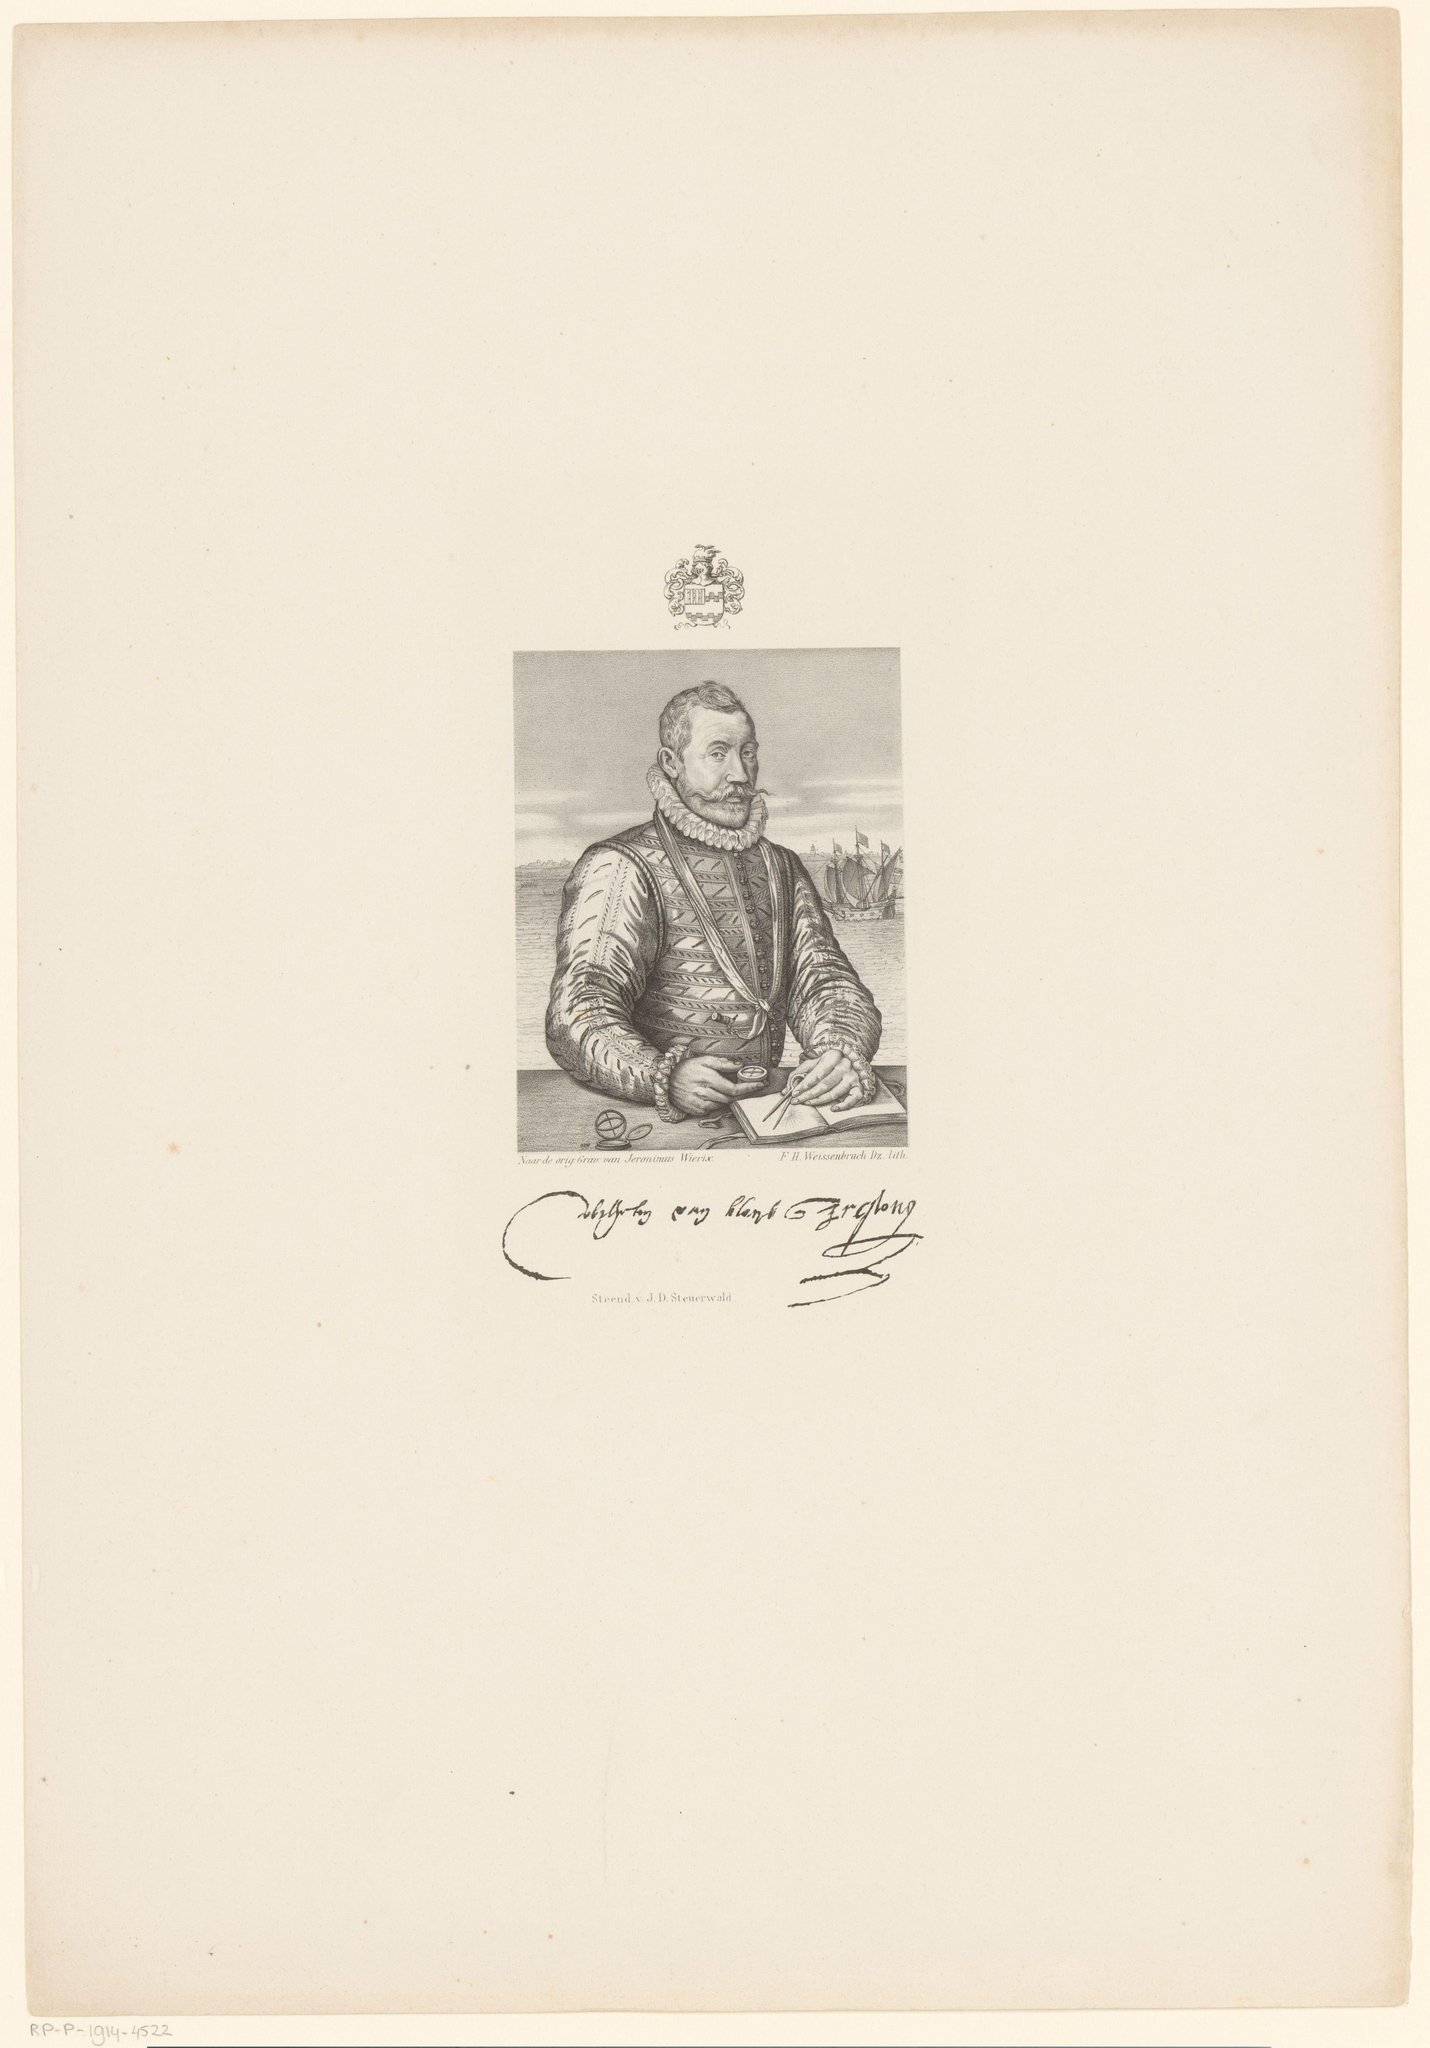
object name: print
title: Portret van Willem Bloys van Treslong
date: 1858-1862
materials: paper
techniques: lithograph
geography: the hague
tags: historical persons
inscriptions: collector's mark: Lugt 2228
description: Vermeld op object: Naar (...) Jeronimus Wierix. Is echter naar een prent van Johannes [H] Wierix. Prent uit: Jonge, J.C. de. Geschiedenis van het Nederlandsche zeewezen. Haarlem: Jonge, J.K.J. de, 1858-62.